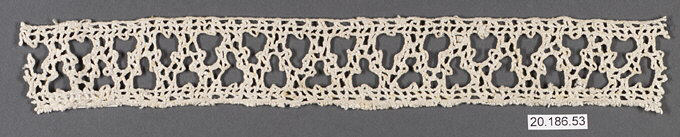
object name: insertion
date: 1501-1600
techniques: lace